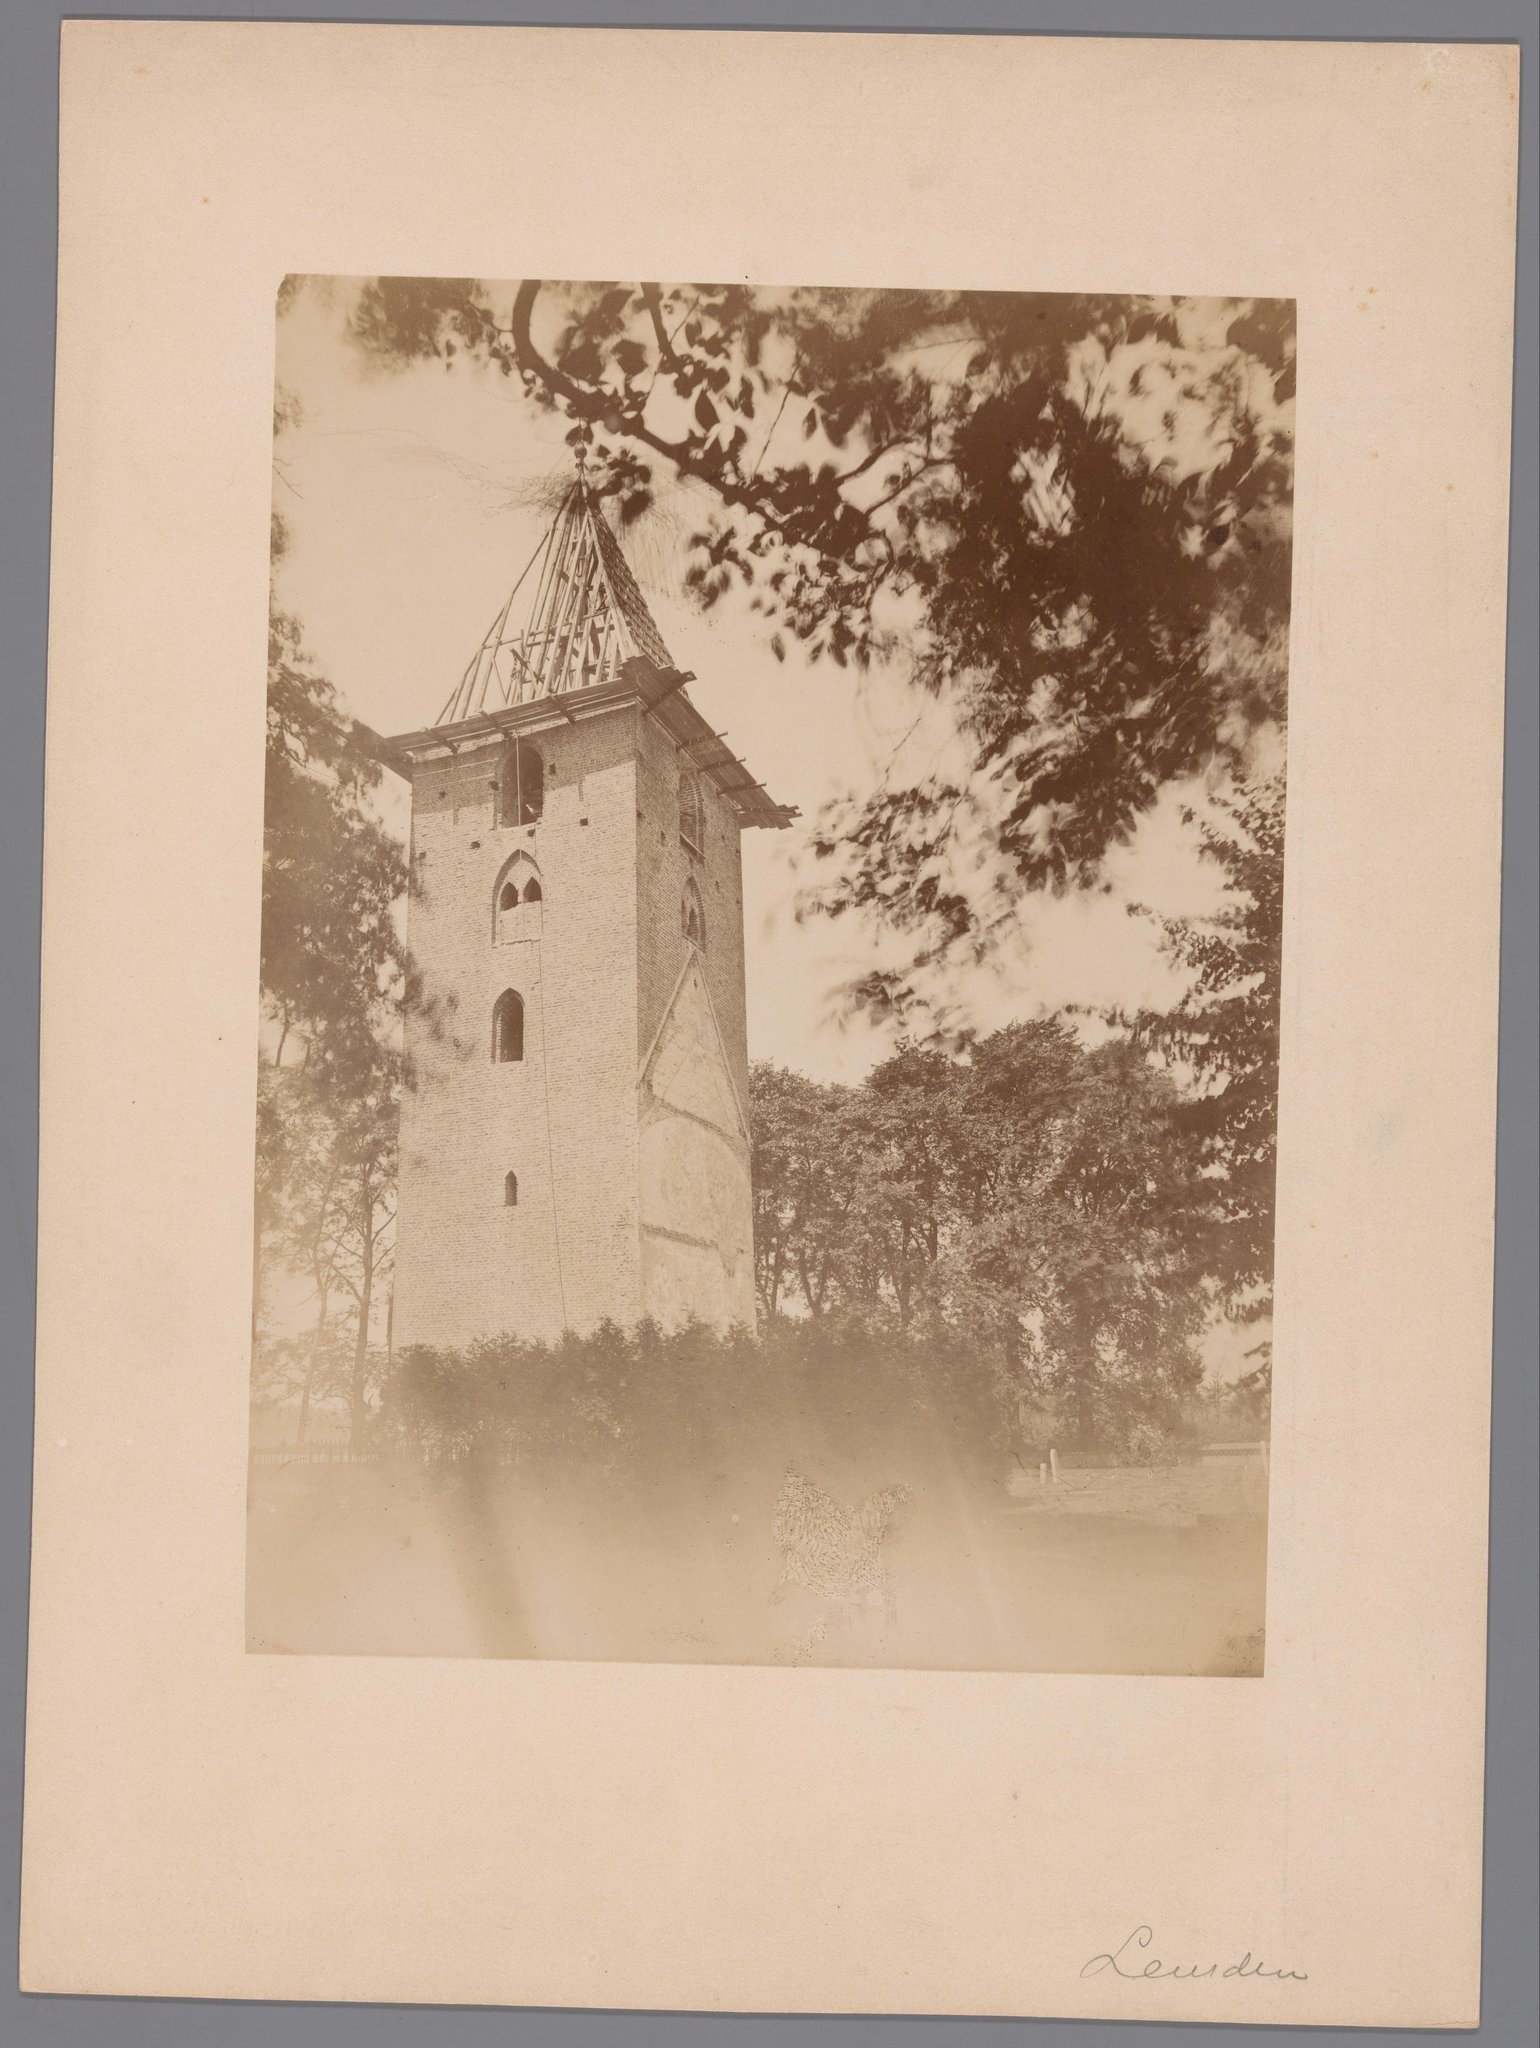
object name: photograph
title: Toren van de Hervormde Kerk te Leusden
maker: anoniem (monumentenzorg)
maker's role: fotograaf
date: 1901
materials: cardboard, photographic support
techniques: albumen print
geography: leusden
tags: parts of church exterior and annexes: tower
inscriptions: annotation: ‘Leusden’, annotation: ‘Leusden-toren (U.)/ bij Amersfoort’